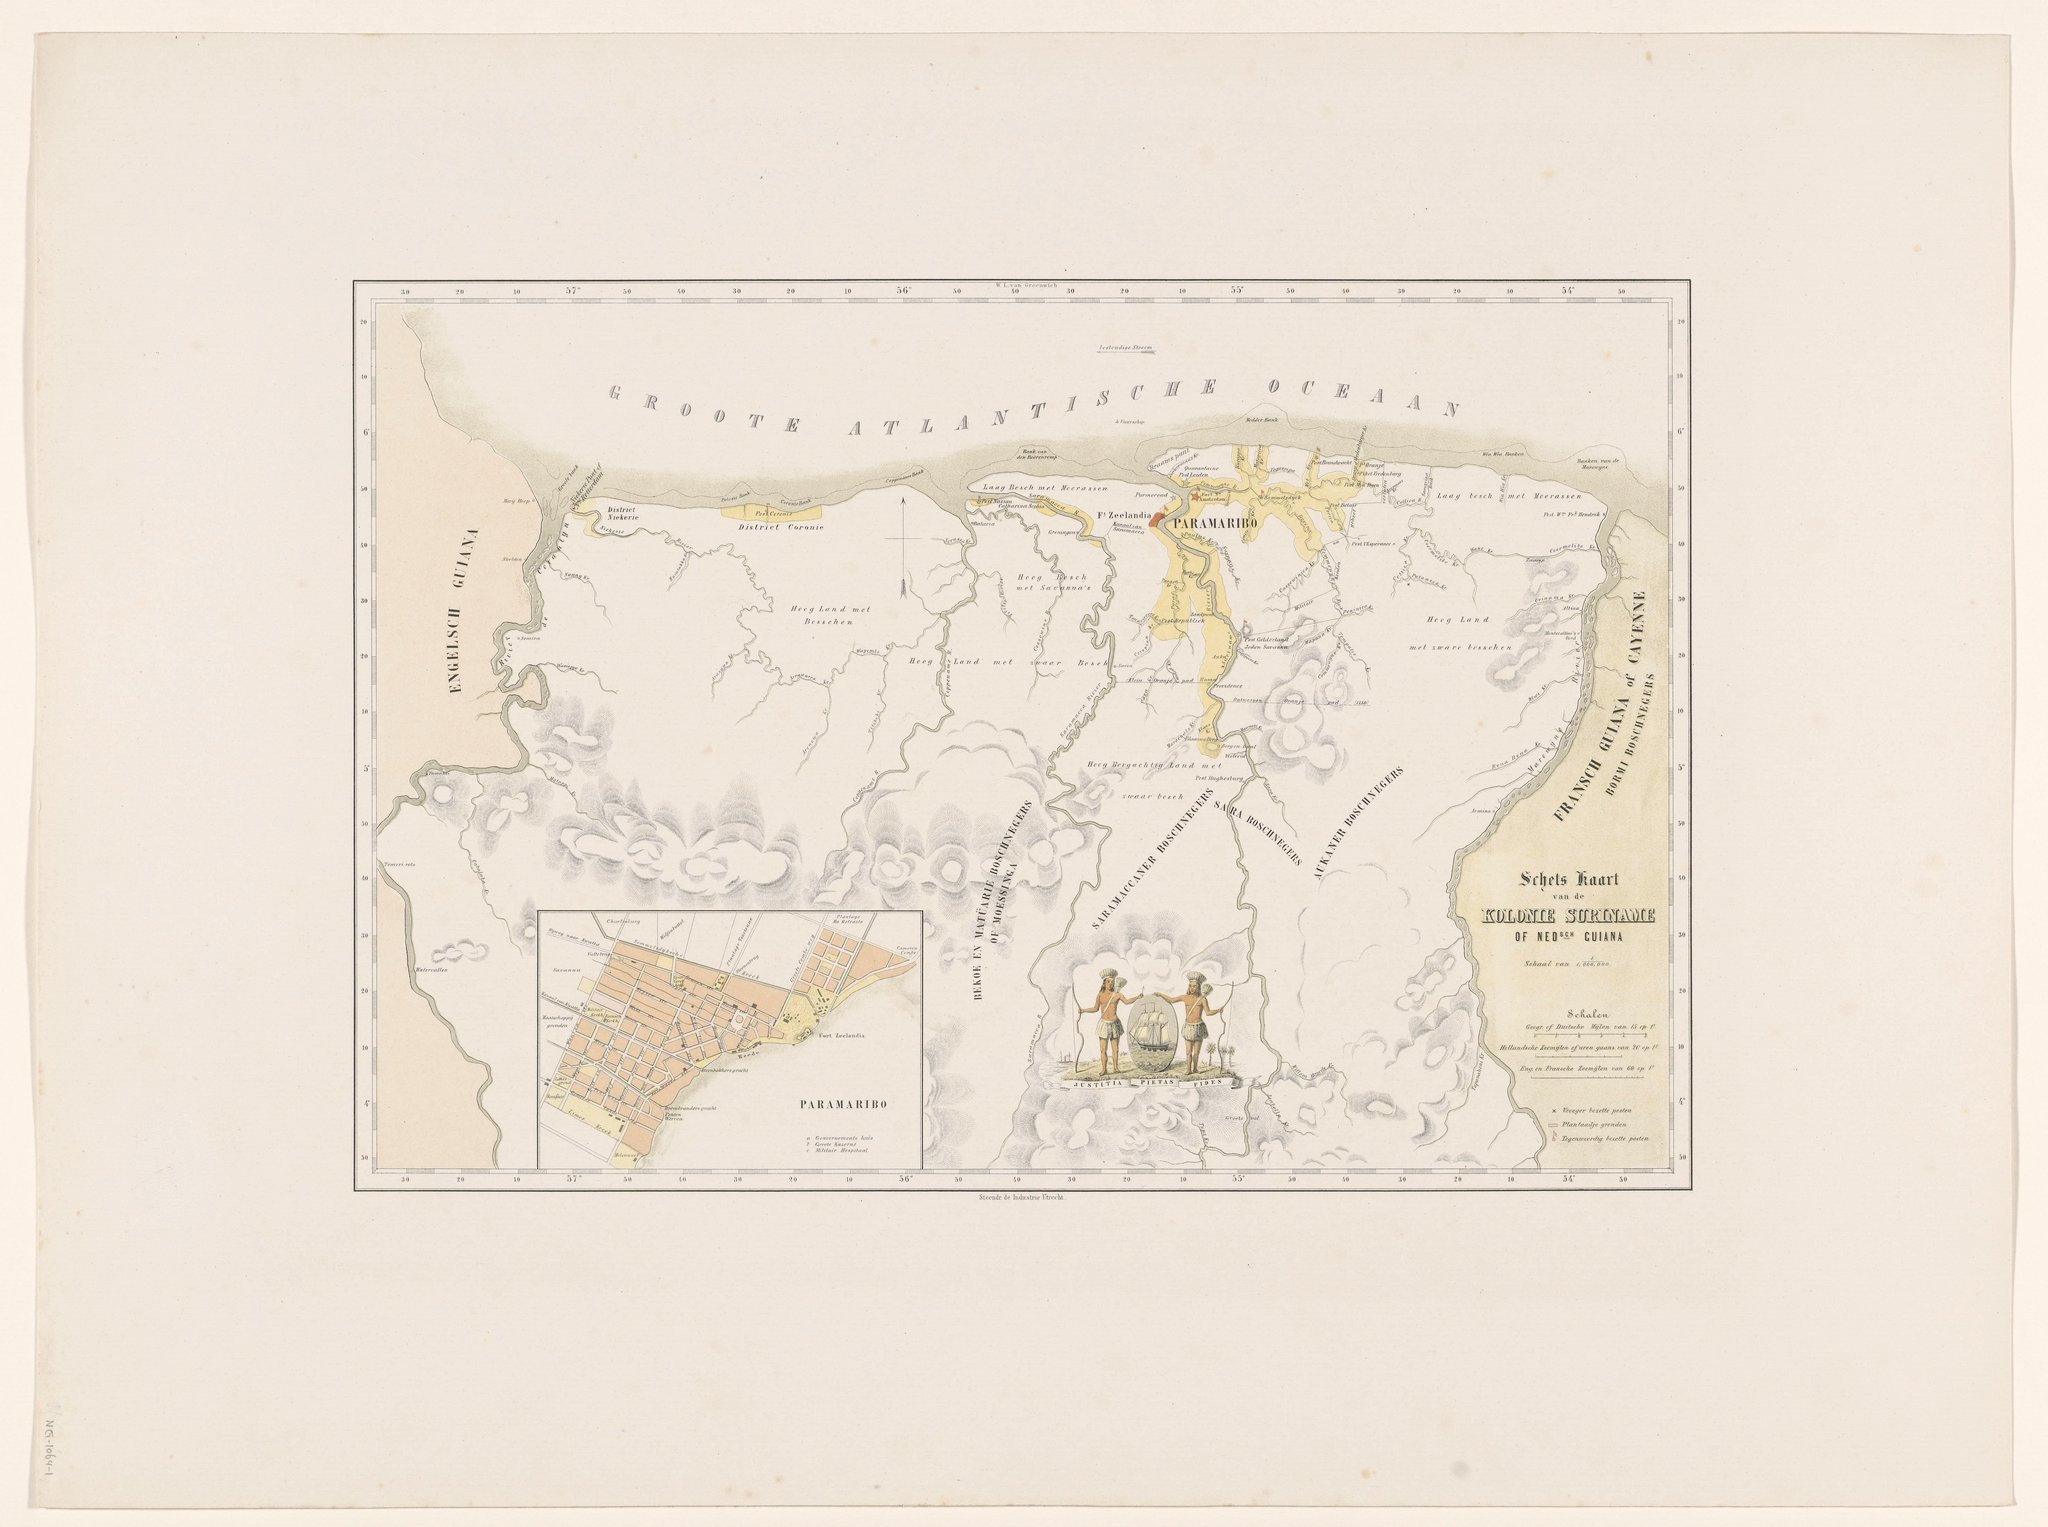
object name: map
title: Schets Kaart van de Kolonie Suriname of Ned.sche Guiana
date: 1860-1862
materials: paper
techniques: lithograph, hand coloring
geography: netherlands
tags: maps of separate countries or regions, suriname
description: Gepubliceerd in het plaatwerk: Gezigten uit Neerland’s West-Indien / naar de natuur geteekend, en beschreven door G.W.C. Voorduin ; op steen gebragt door J.E. van Heemskerck van Beest. - Amsterdam : Frans Buffa en Zonen, [1860-1862] Koeman dateert de kaart op 1877 op bais van de uitgave van het plaatwerk uit 1877. Volgens de UB UvA is dit plaatwerk al eerder verschenen in 1860-1862.